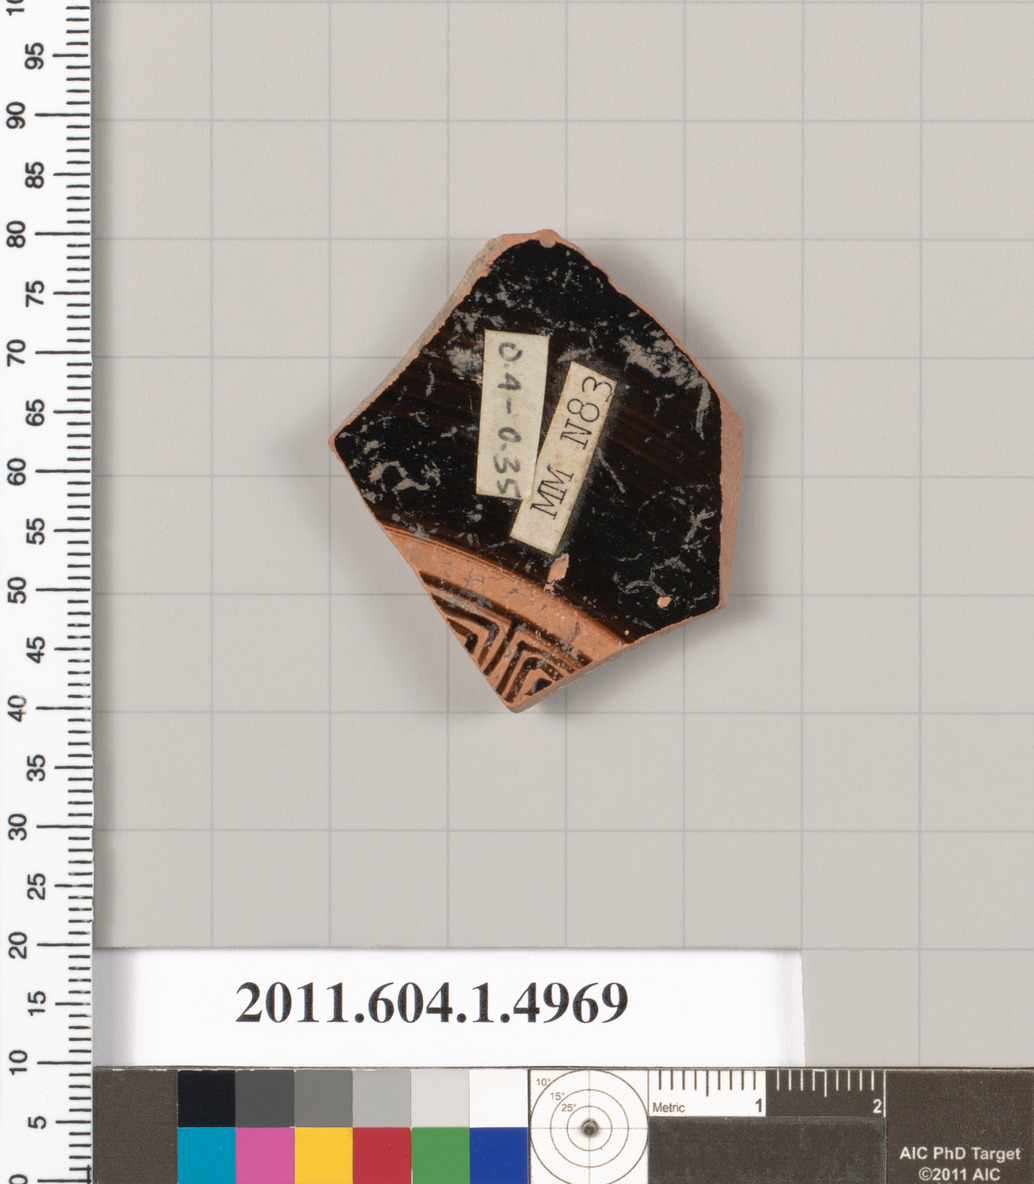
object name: kylix fragment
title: Terracotta fragment of a kylix (drinking cup)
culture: greek, attic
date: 475-451 BCE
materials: terracotta